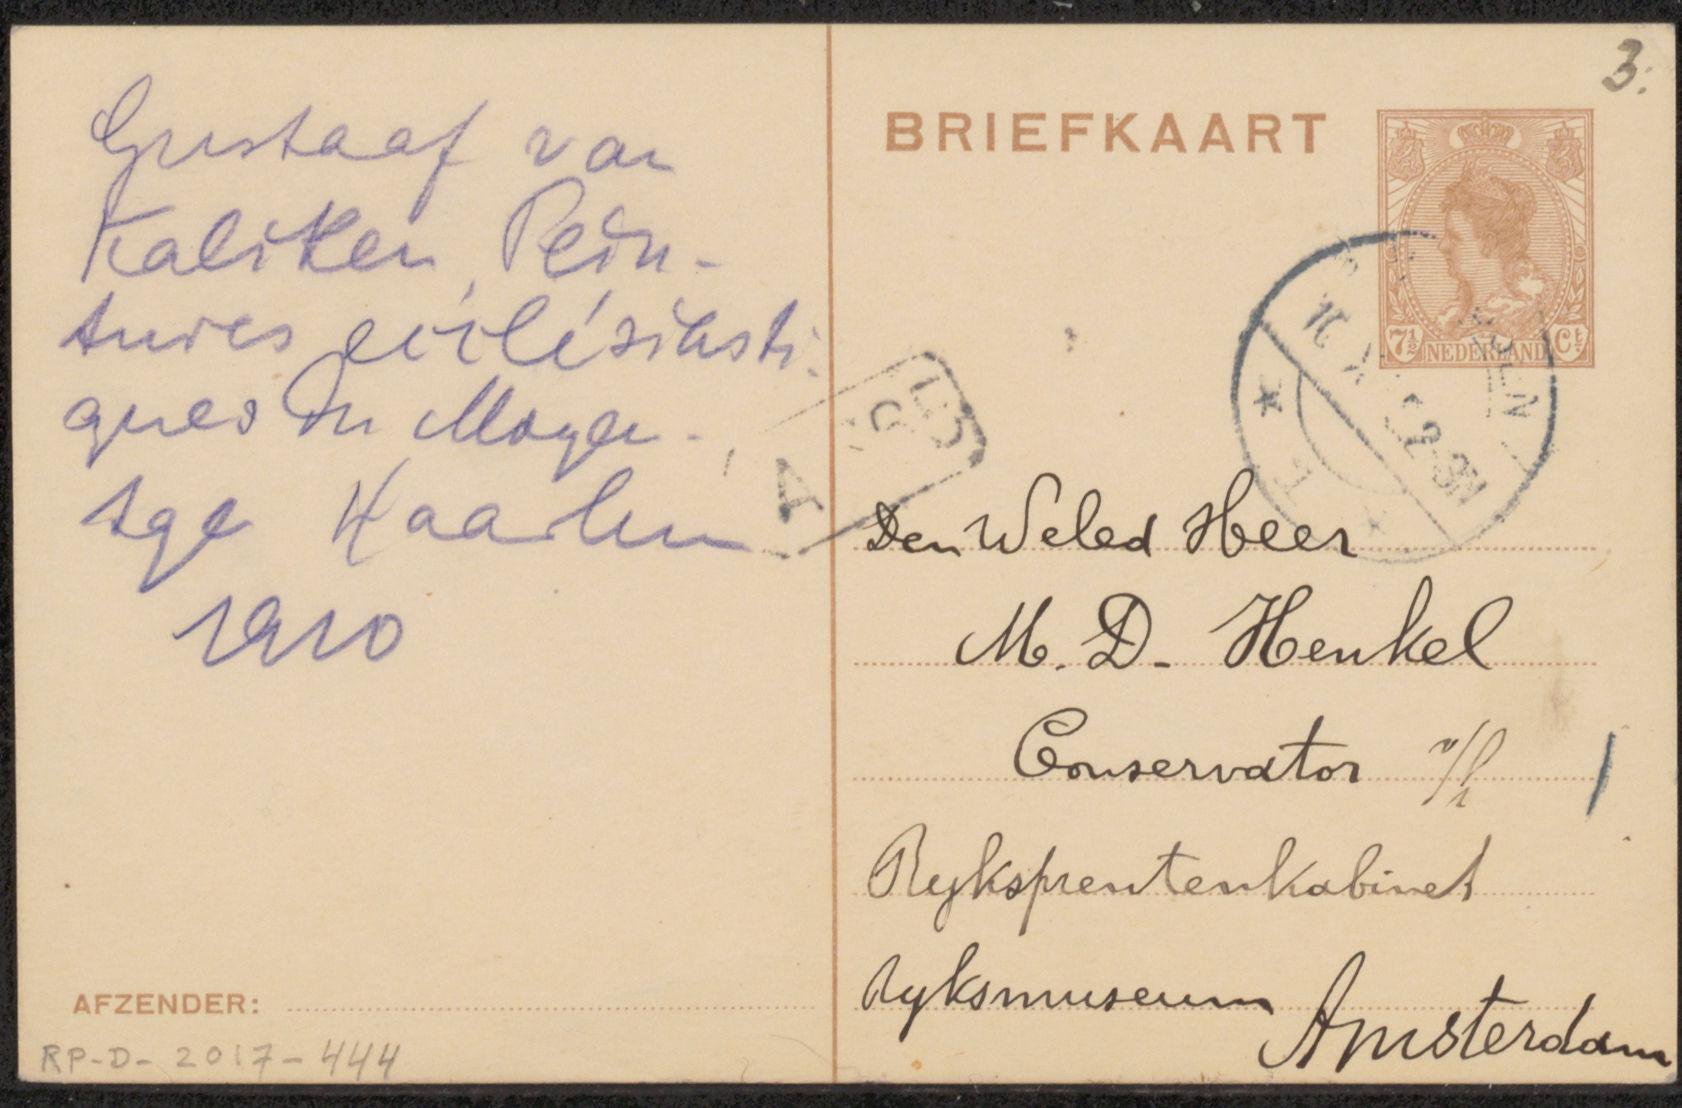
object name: postcard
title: Briefkaart aan Max Dittmar Henkel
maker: jacobus henricus maria hagen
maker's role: priest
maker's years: 1865-1937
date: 1925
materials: cardboard, ink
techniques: pen, writing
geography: vaassen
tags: print maker, reinierus albertus ludovicus baron van isendoorn à blois, max dittmar henkel